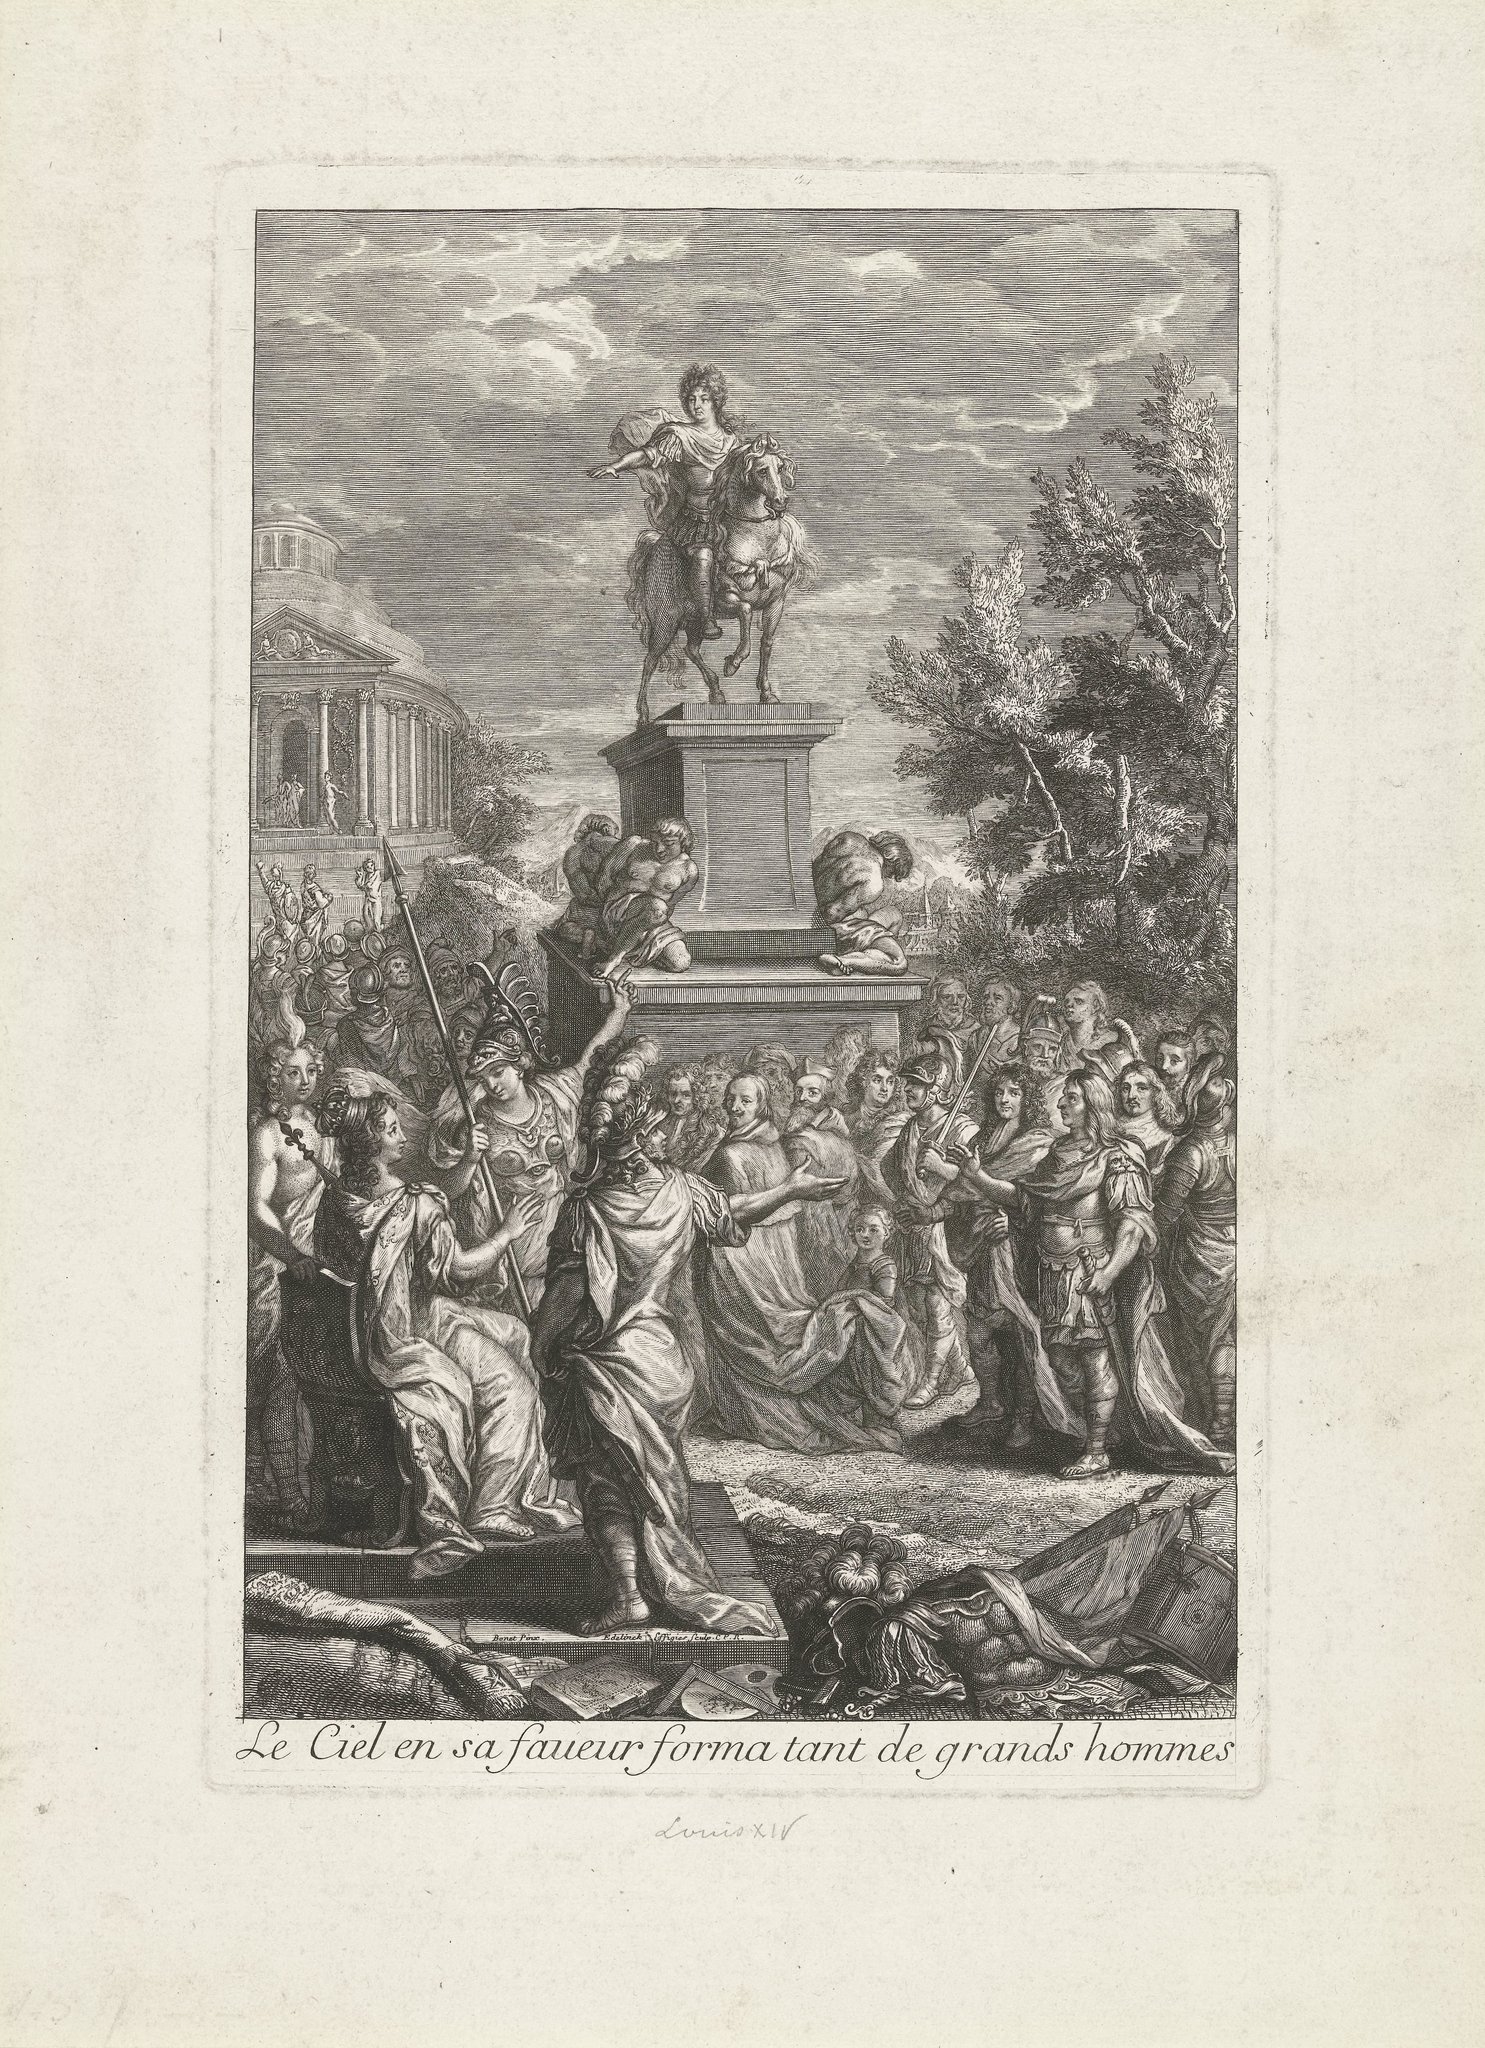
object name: print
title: Ruiterstandbeeld van Lodewijk de XIV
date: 1666-1707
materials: paper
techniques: engraving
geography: paris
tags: bourges, touraine, koning, lodewijk xi (koning van frankrijk)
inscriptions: collector's mark: Lugt 240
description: Ruiterstandbeeld van Lodewijk de XIV, met aan de voet van de sokkel geketende figuren. Rondom het standbeeld een verzameling kopstukken uit de Franse monarchie. Op de voorgrond de zittende personificatie van Frankrijk, bijgestaan door Bellona en Mars.